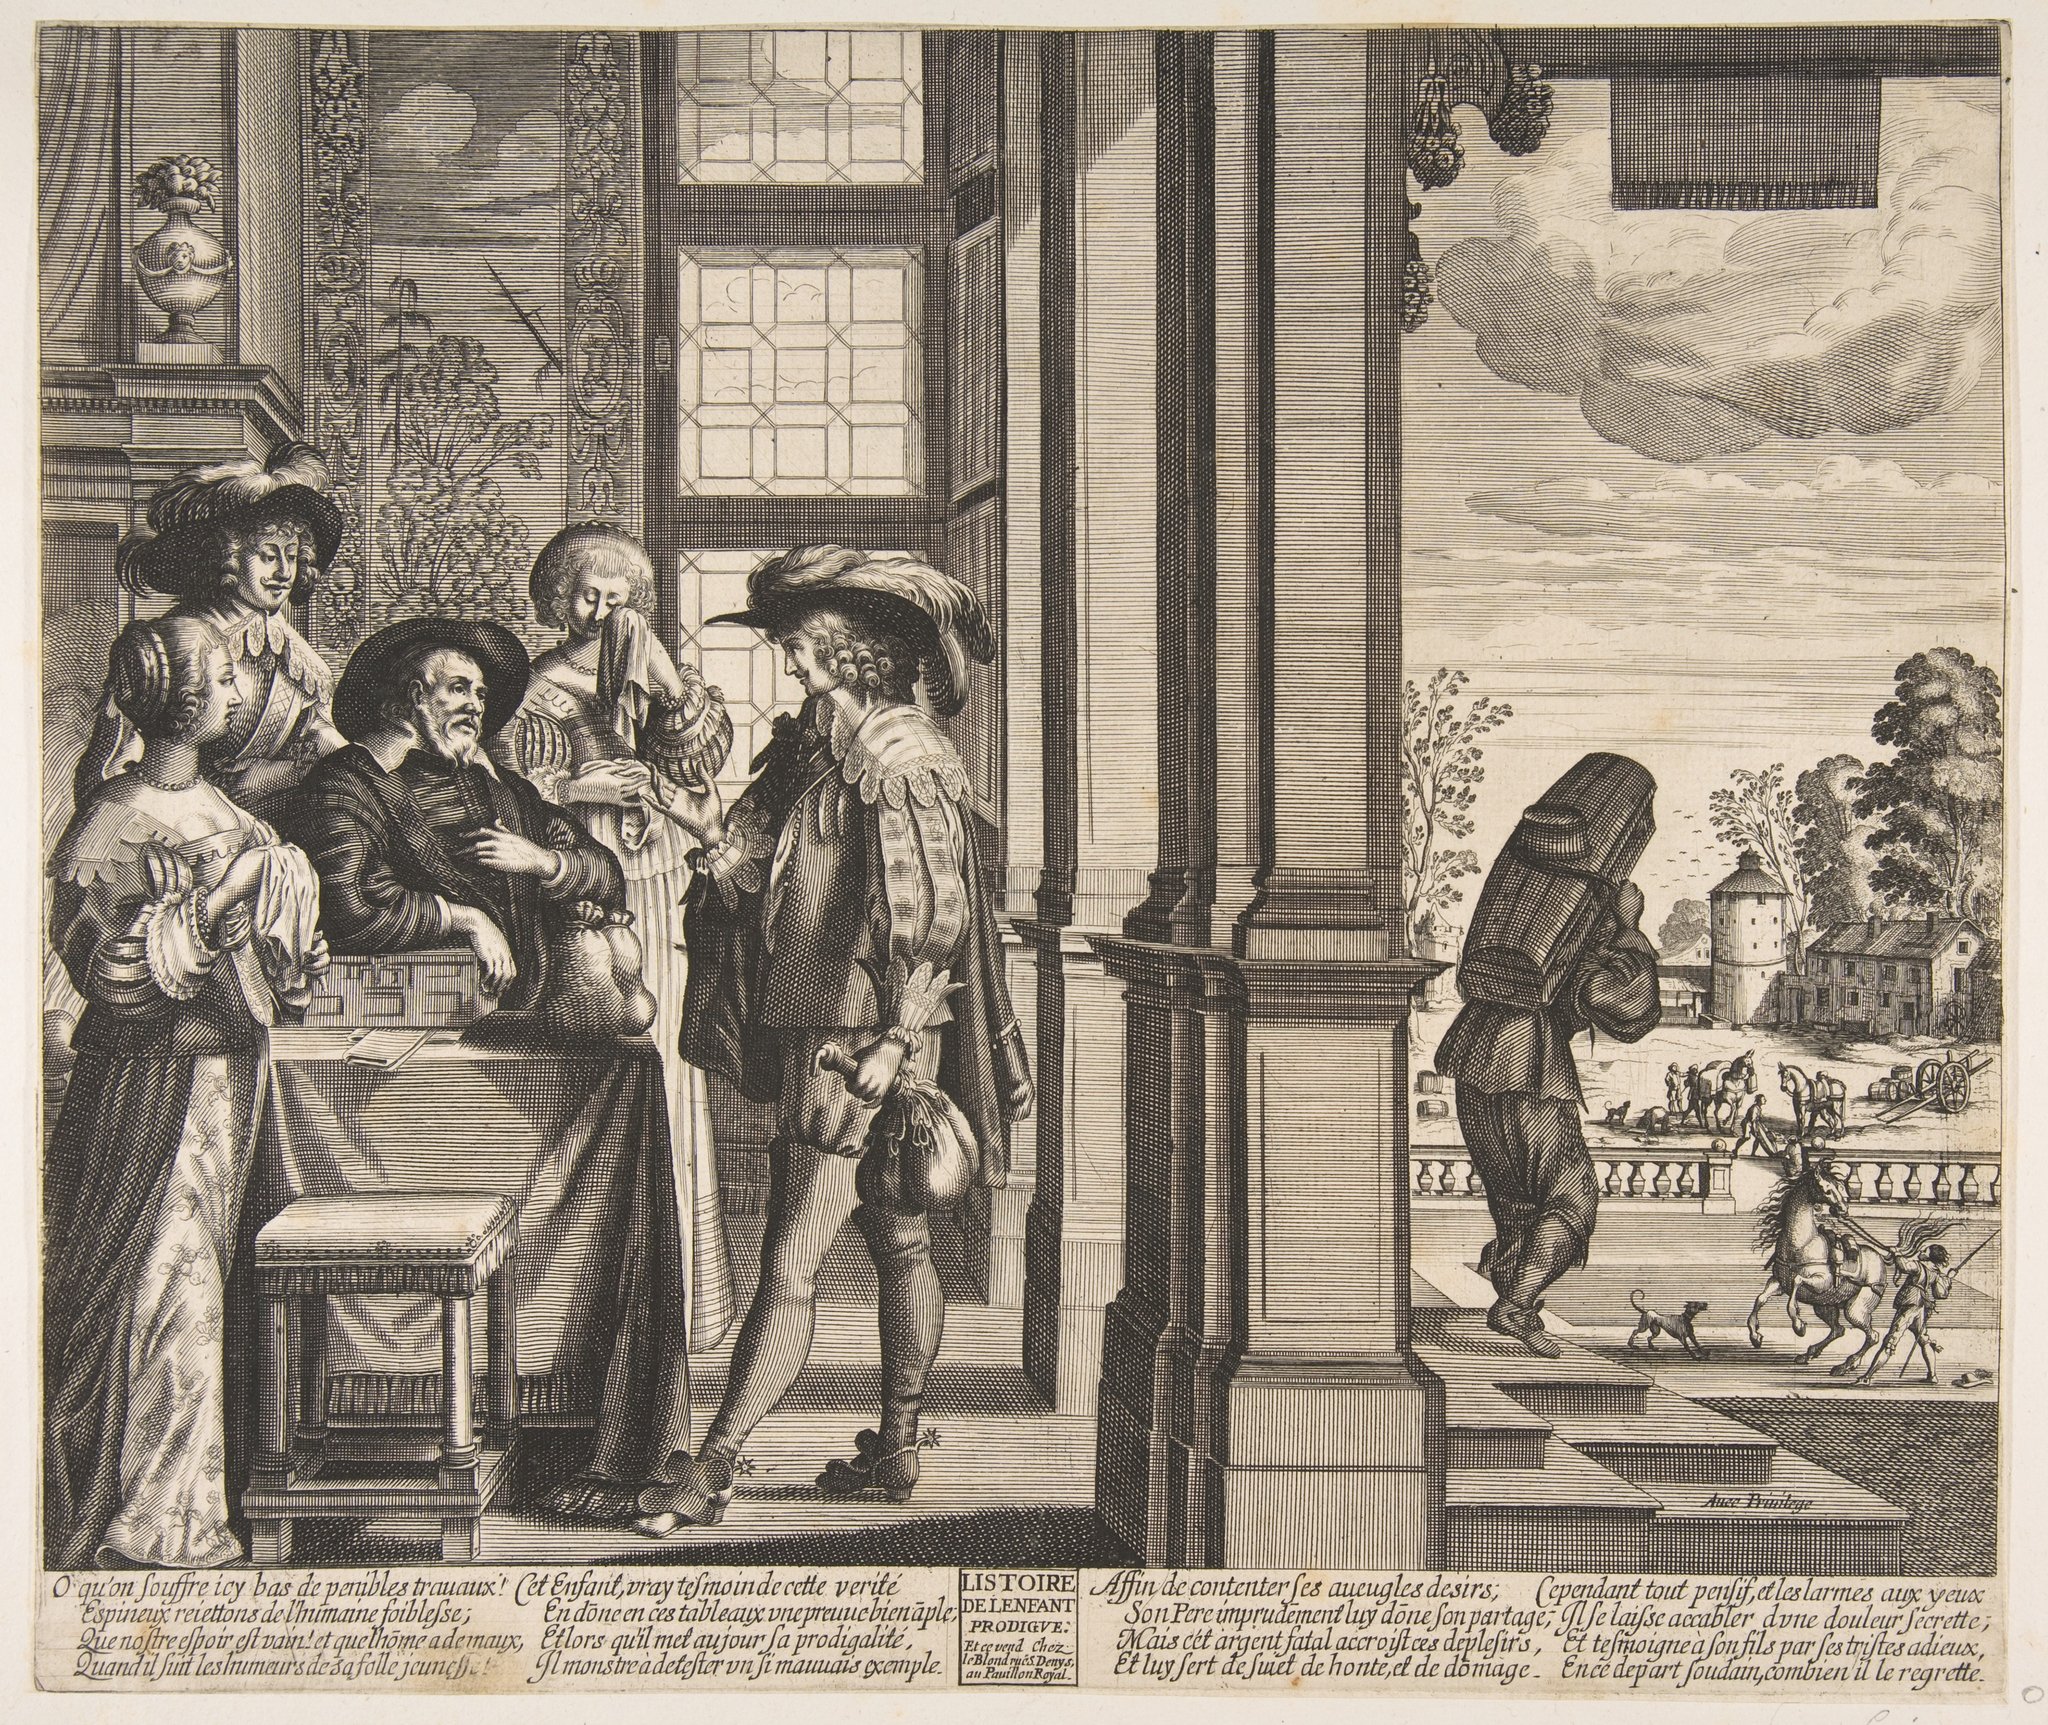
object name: print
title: The Prodigal Son Leaves Home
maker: Anonymous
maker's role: artist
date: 1636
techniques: engraving, etching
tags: interiors,sadness,men,women